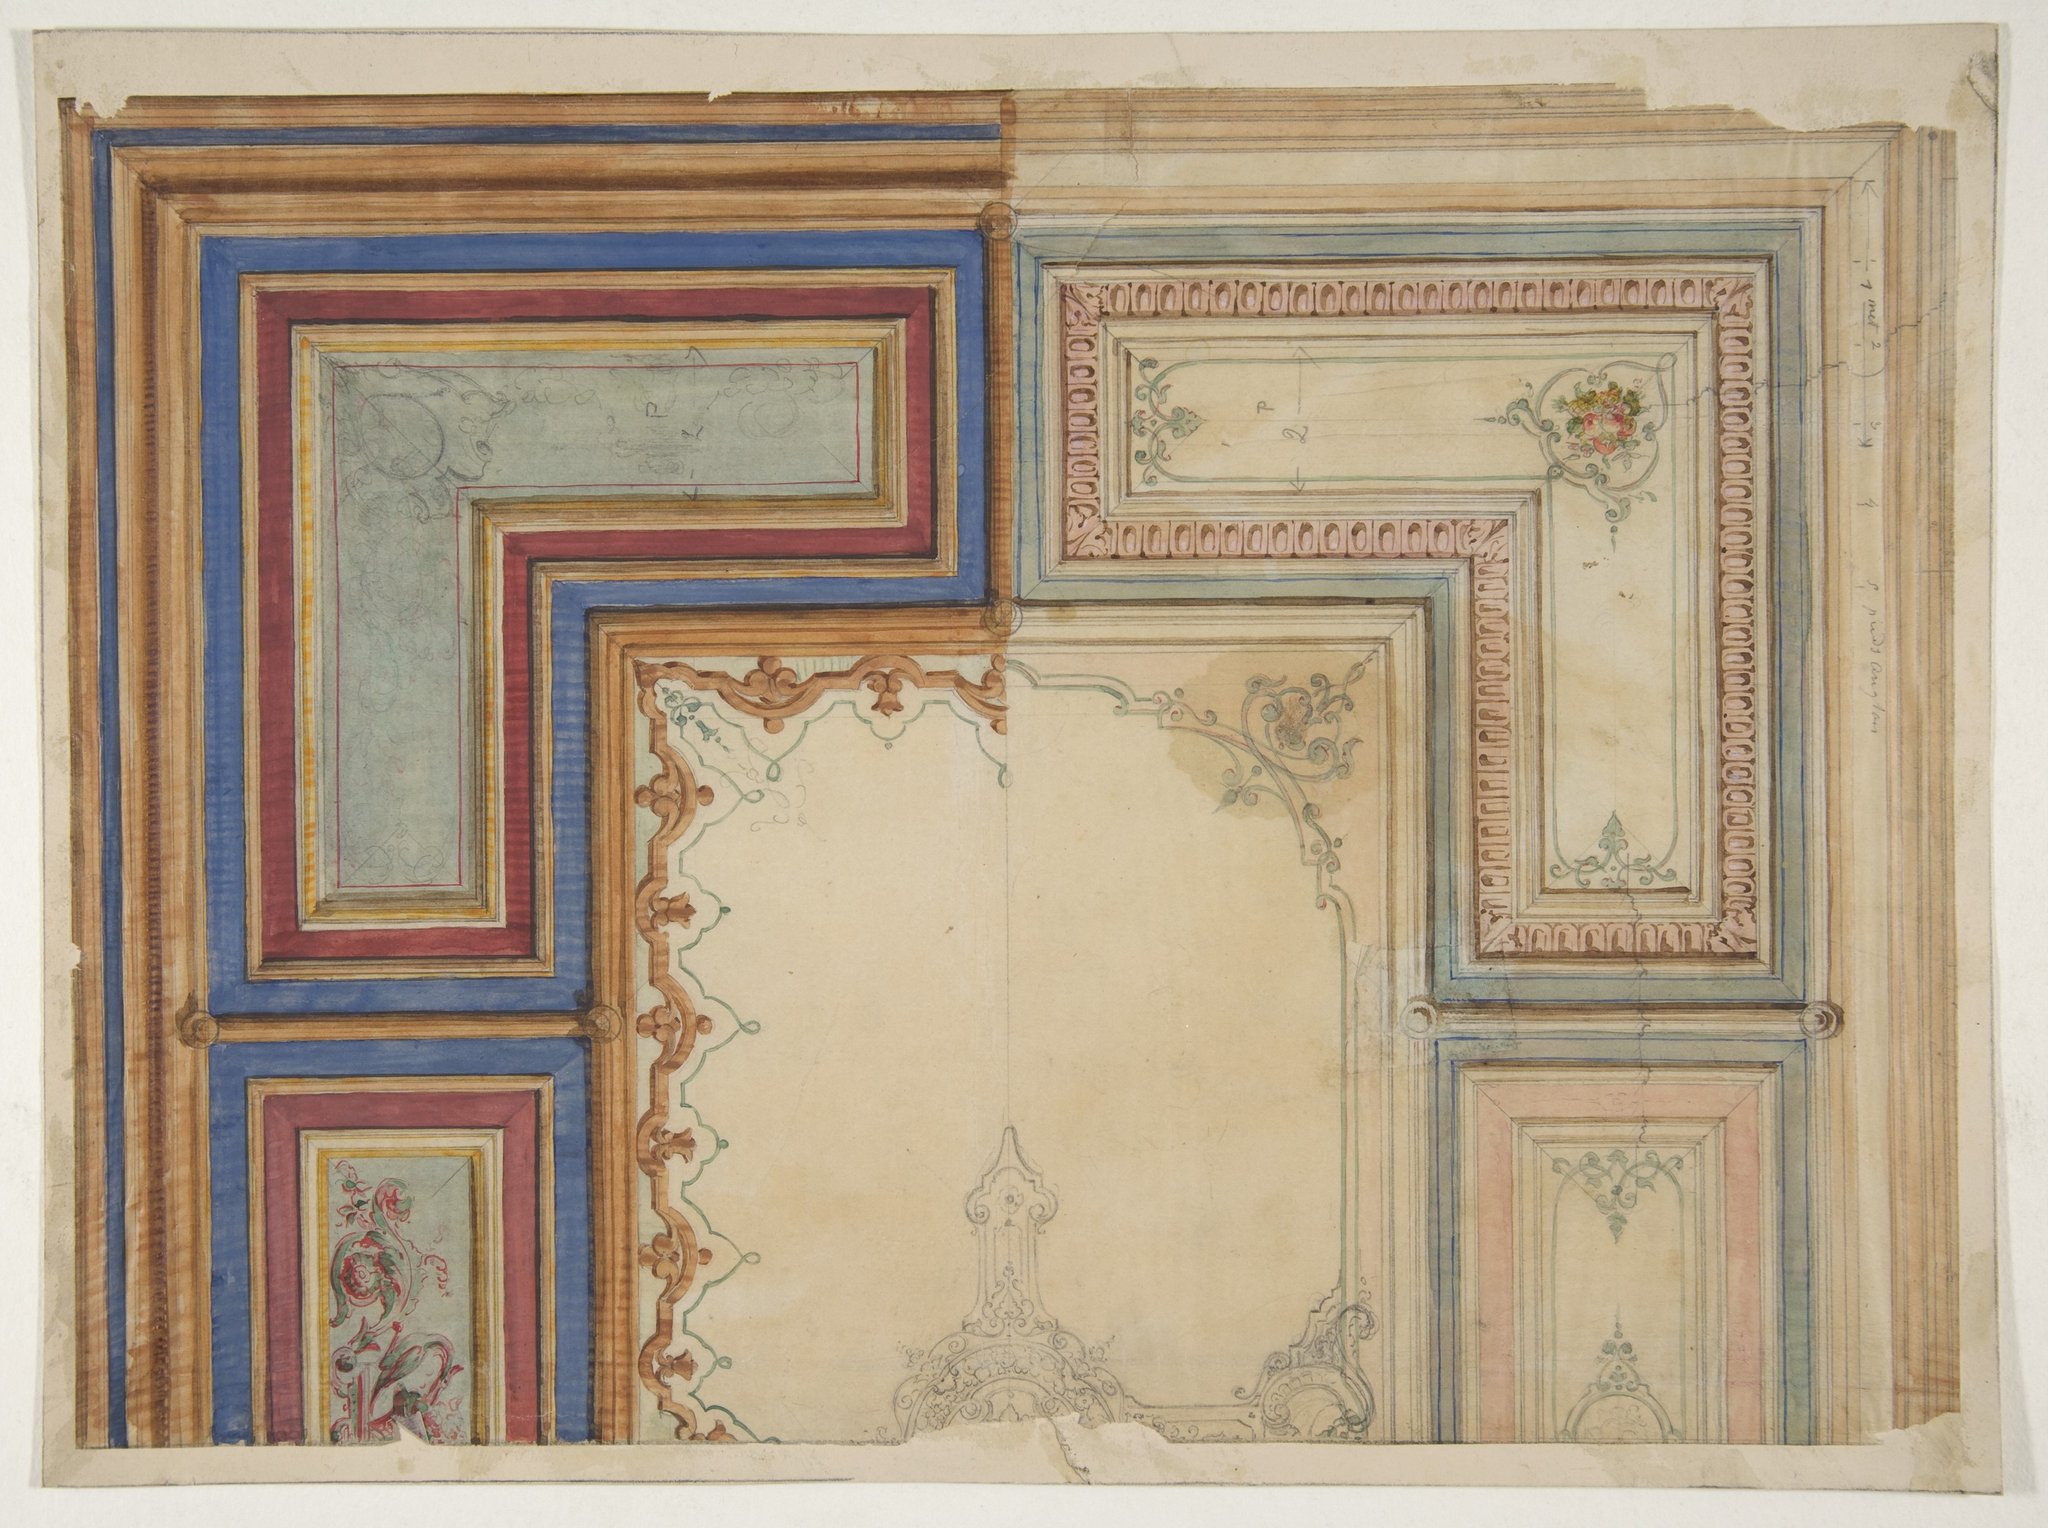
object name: drawing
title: Two alternative designs for the painted decoration of a ceiling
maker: jules-edmond-charles lachaise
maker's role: artist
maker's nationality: french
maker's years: 1897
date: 1830-1897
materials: graphite, paper, watercolor